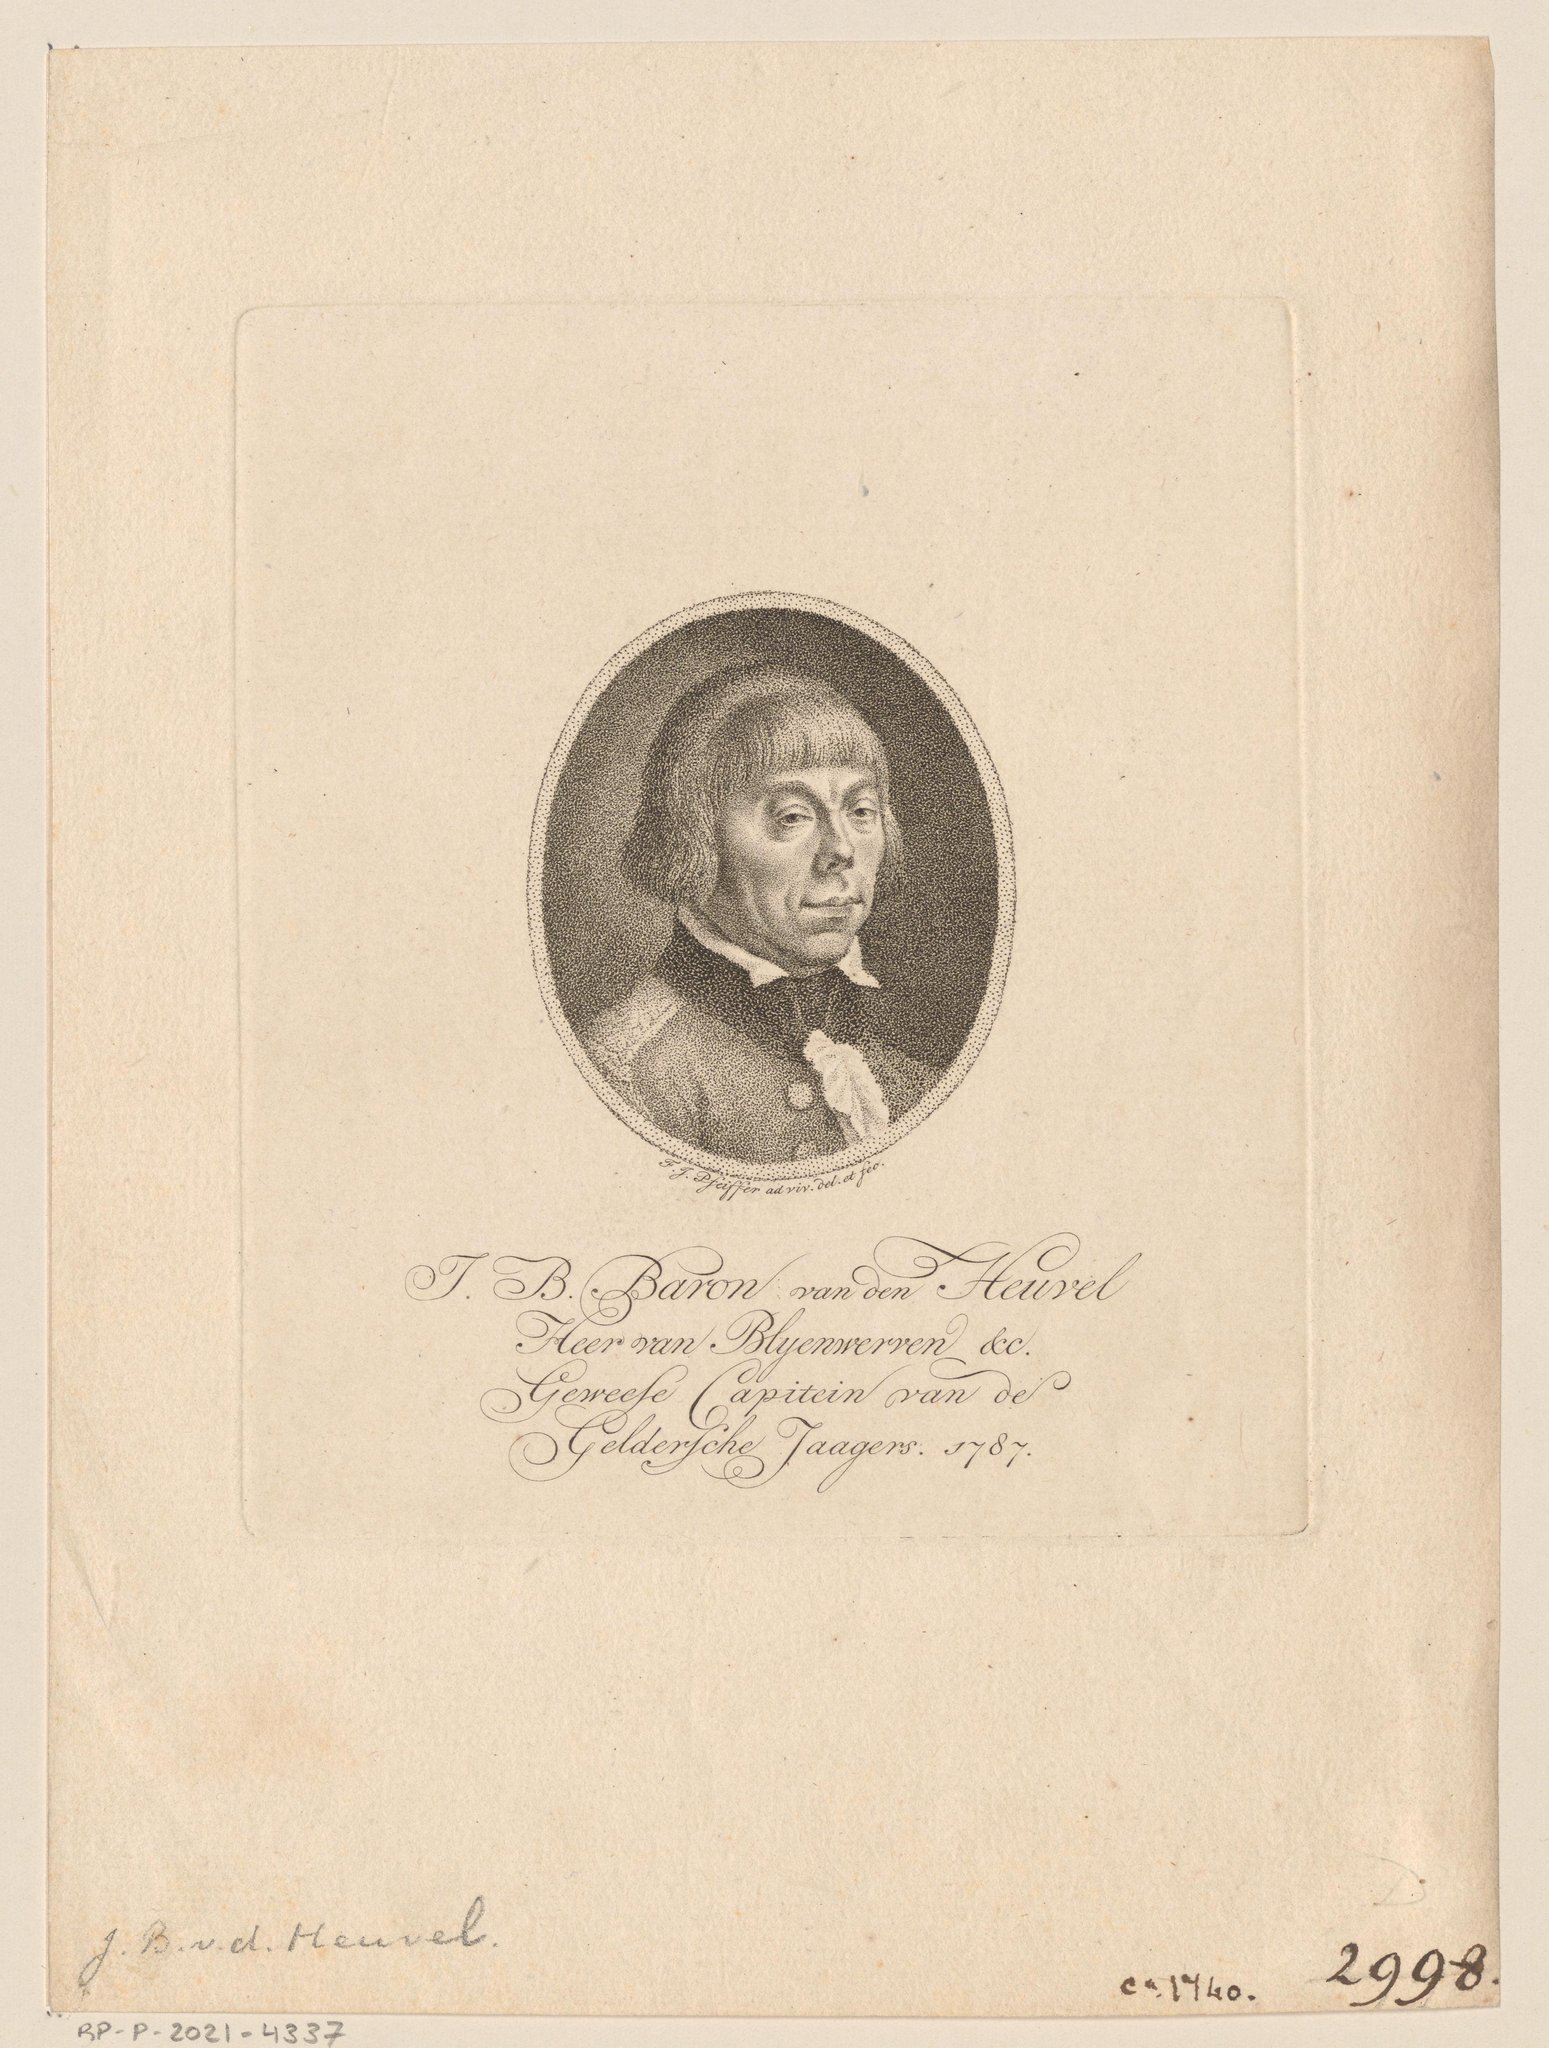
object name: print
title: Portret van Jan Baptist van den Heuvel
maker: françois joseph pfeiffer (i)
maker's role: print maker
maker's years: 1741-1807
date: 1787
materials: paper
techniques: engraving, etching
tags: historical persons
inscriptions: inscription: ‘ca. 1740 2998’